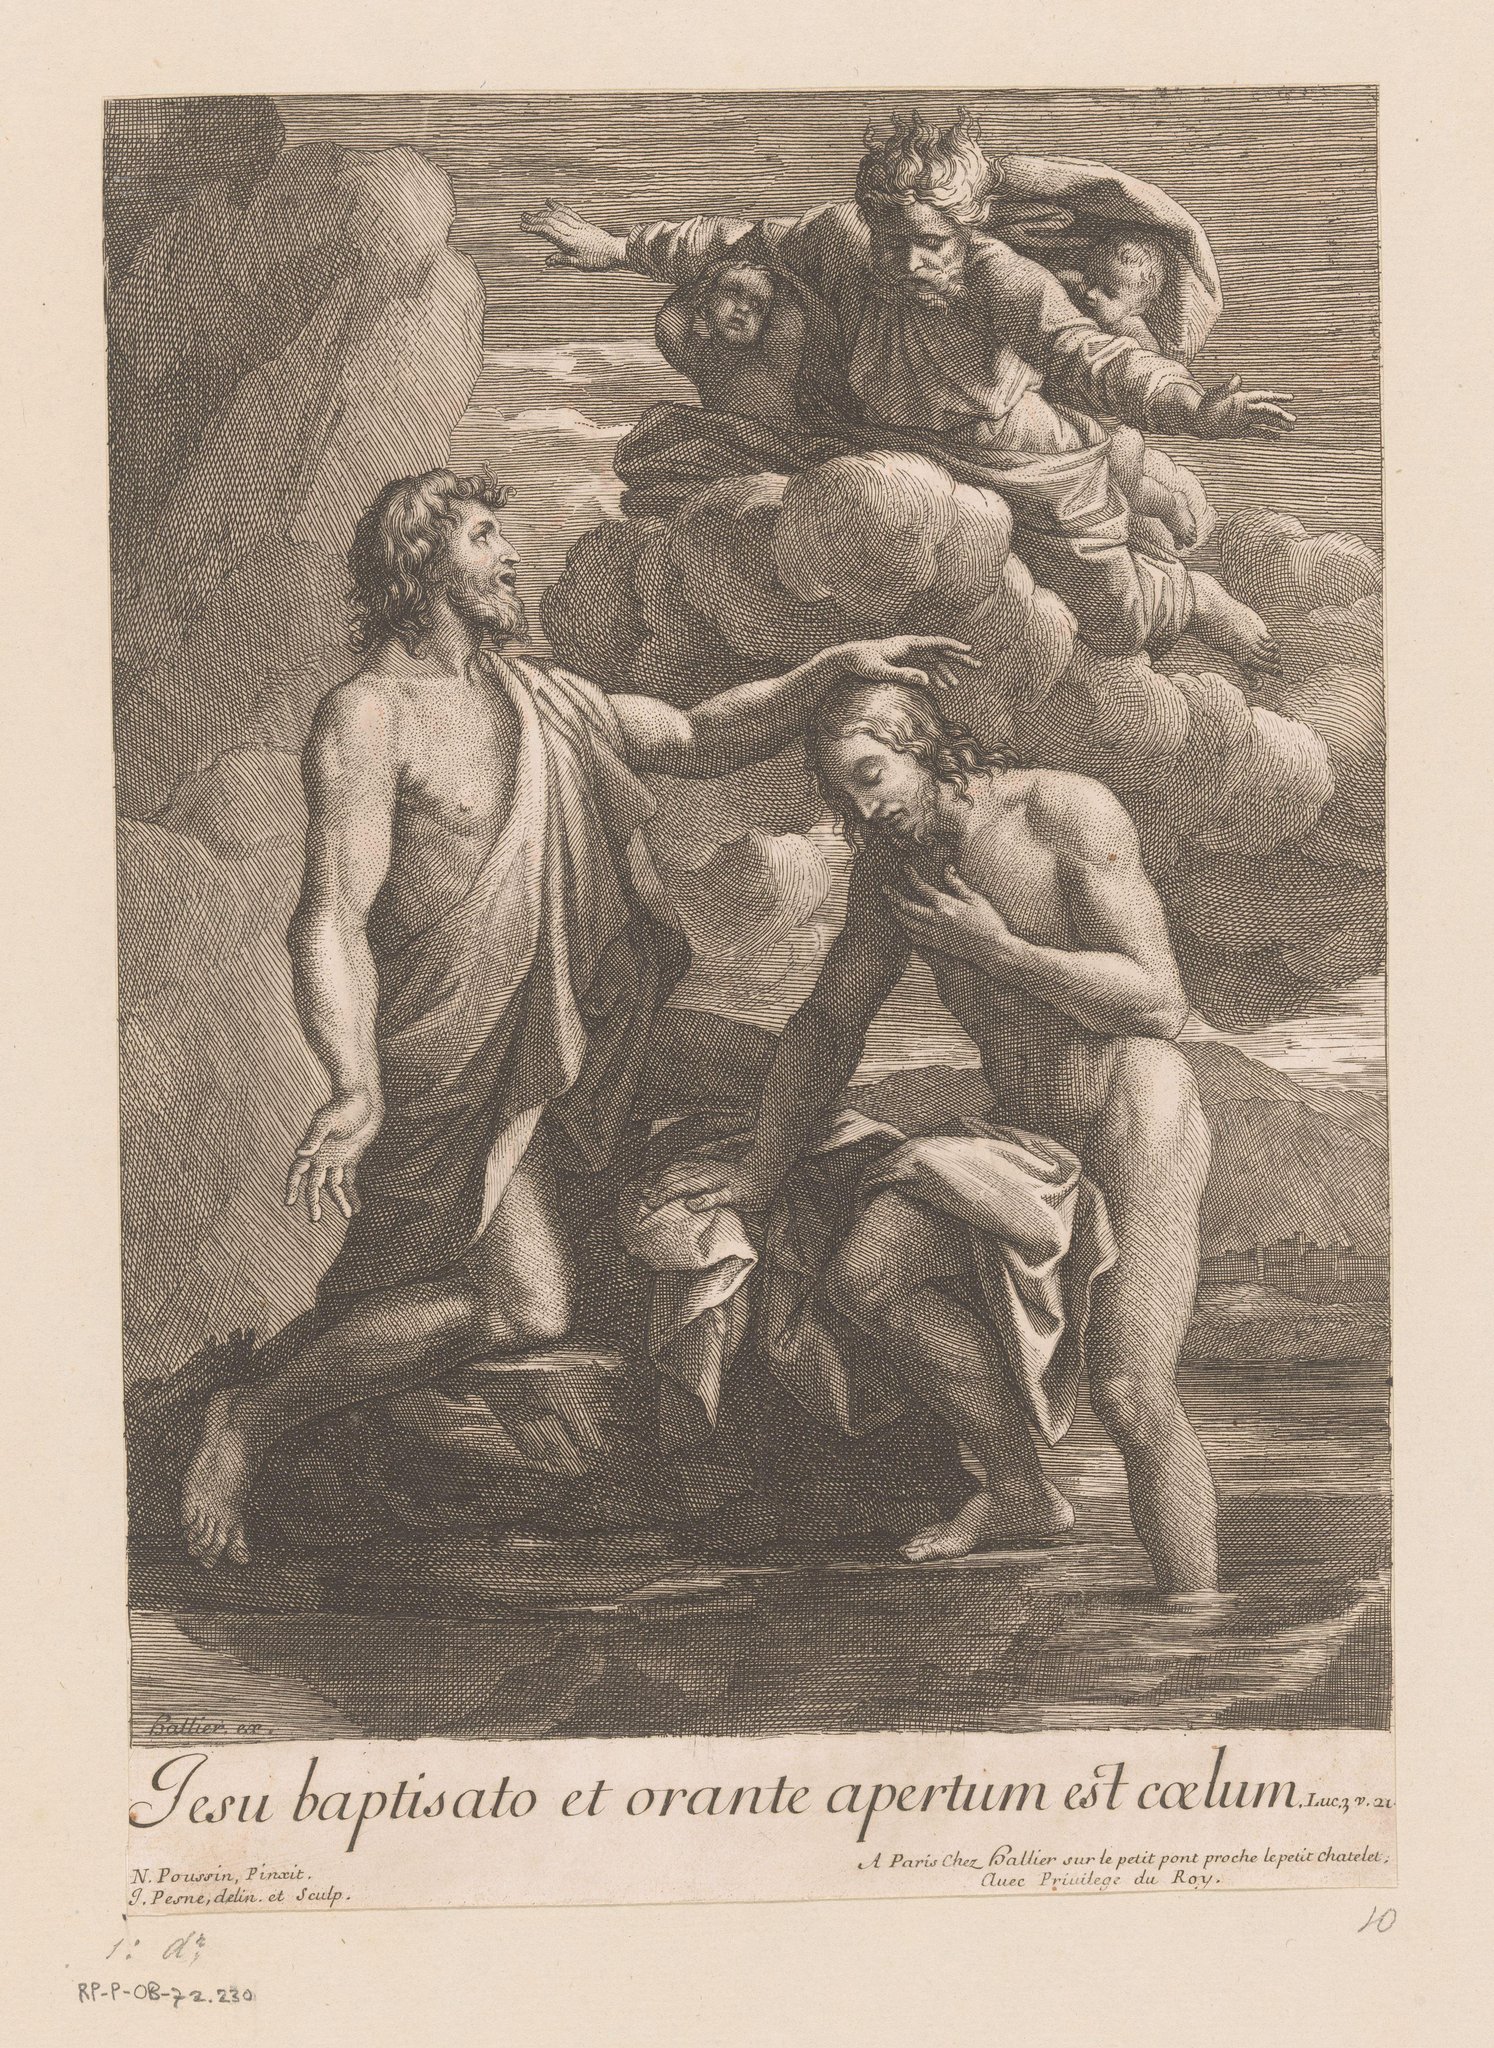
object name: print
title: Jesu baptisato et orante apertum est caelum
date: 1638-1686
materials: paper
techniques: engraving, etching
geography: paris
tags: baptism of christ in the river jordan: john the baptist pouring out water on christ's head: the holy ghost descends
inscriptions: collector's mark: Lugt 240